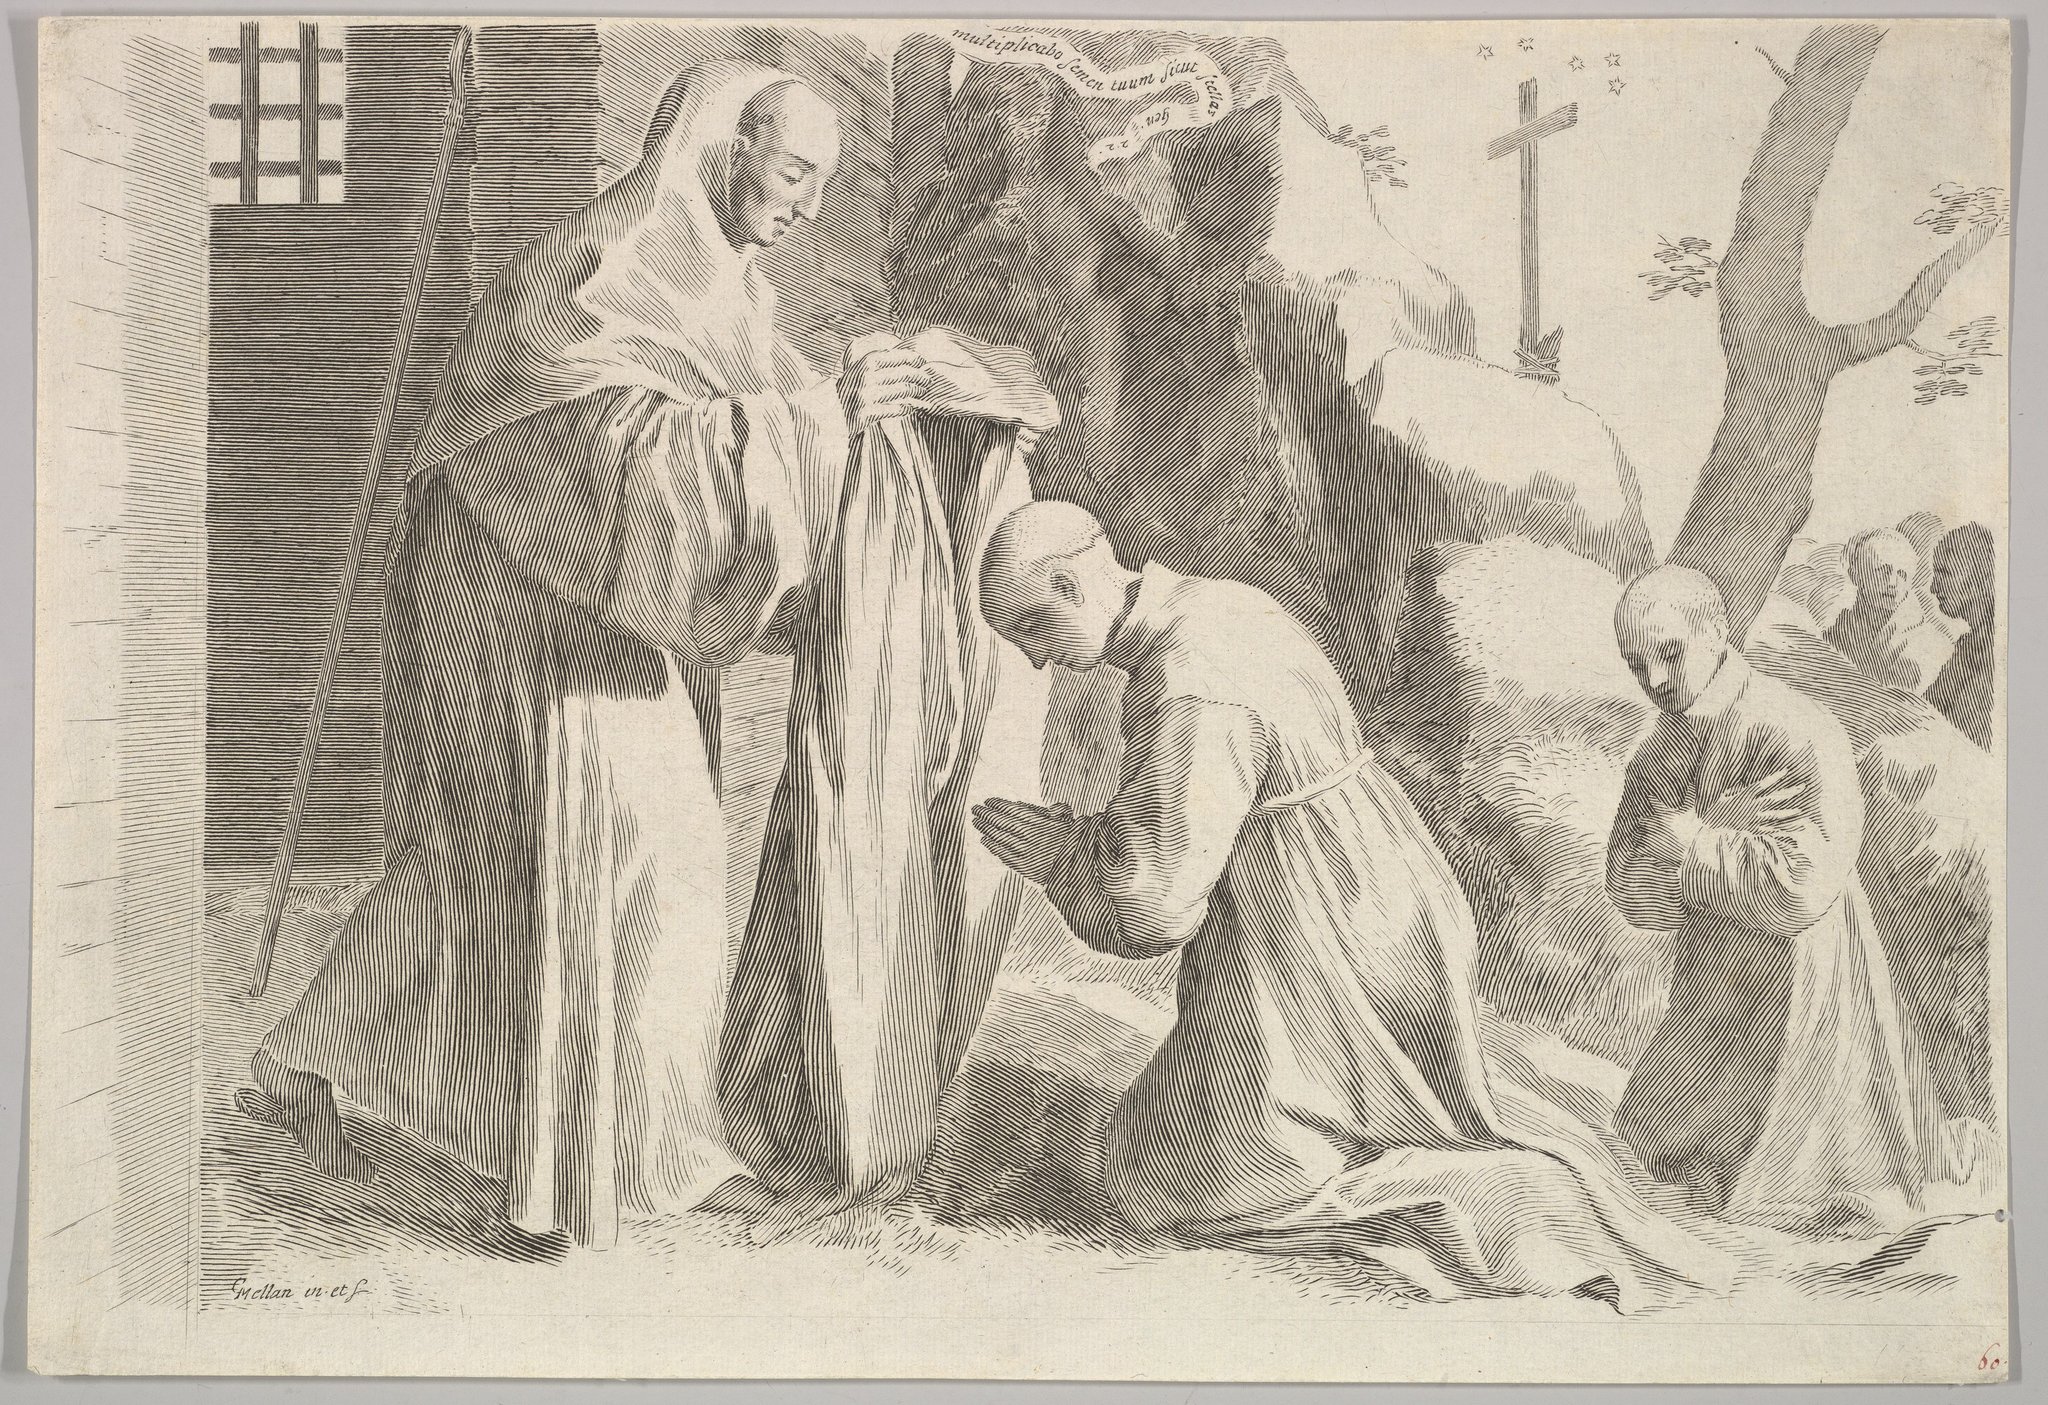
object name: print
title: St. Bernard Receives a Monk's Habit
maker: claude mellan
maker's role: artist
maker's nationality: french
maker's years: 1598-1688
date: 1600-1688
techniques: engraving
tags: cross,monks,saints